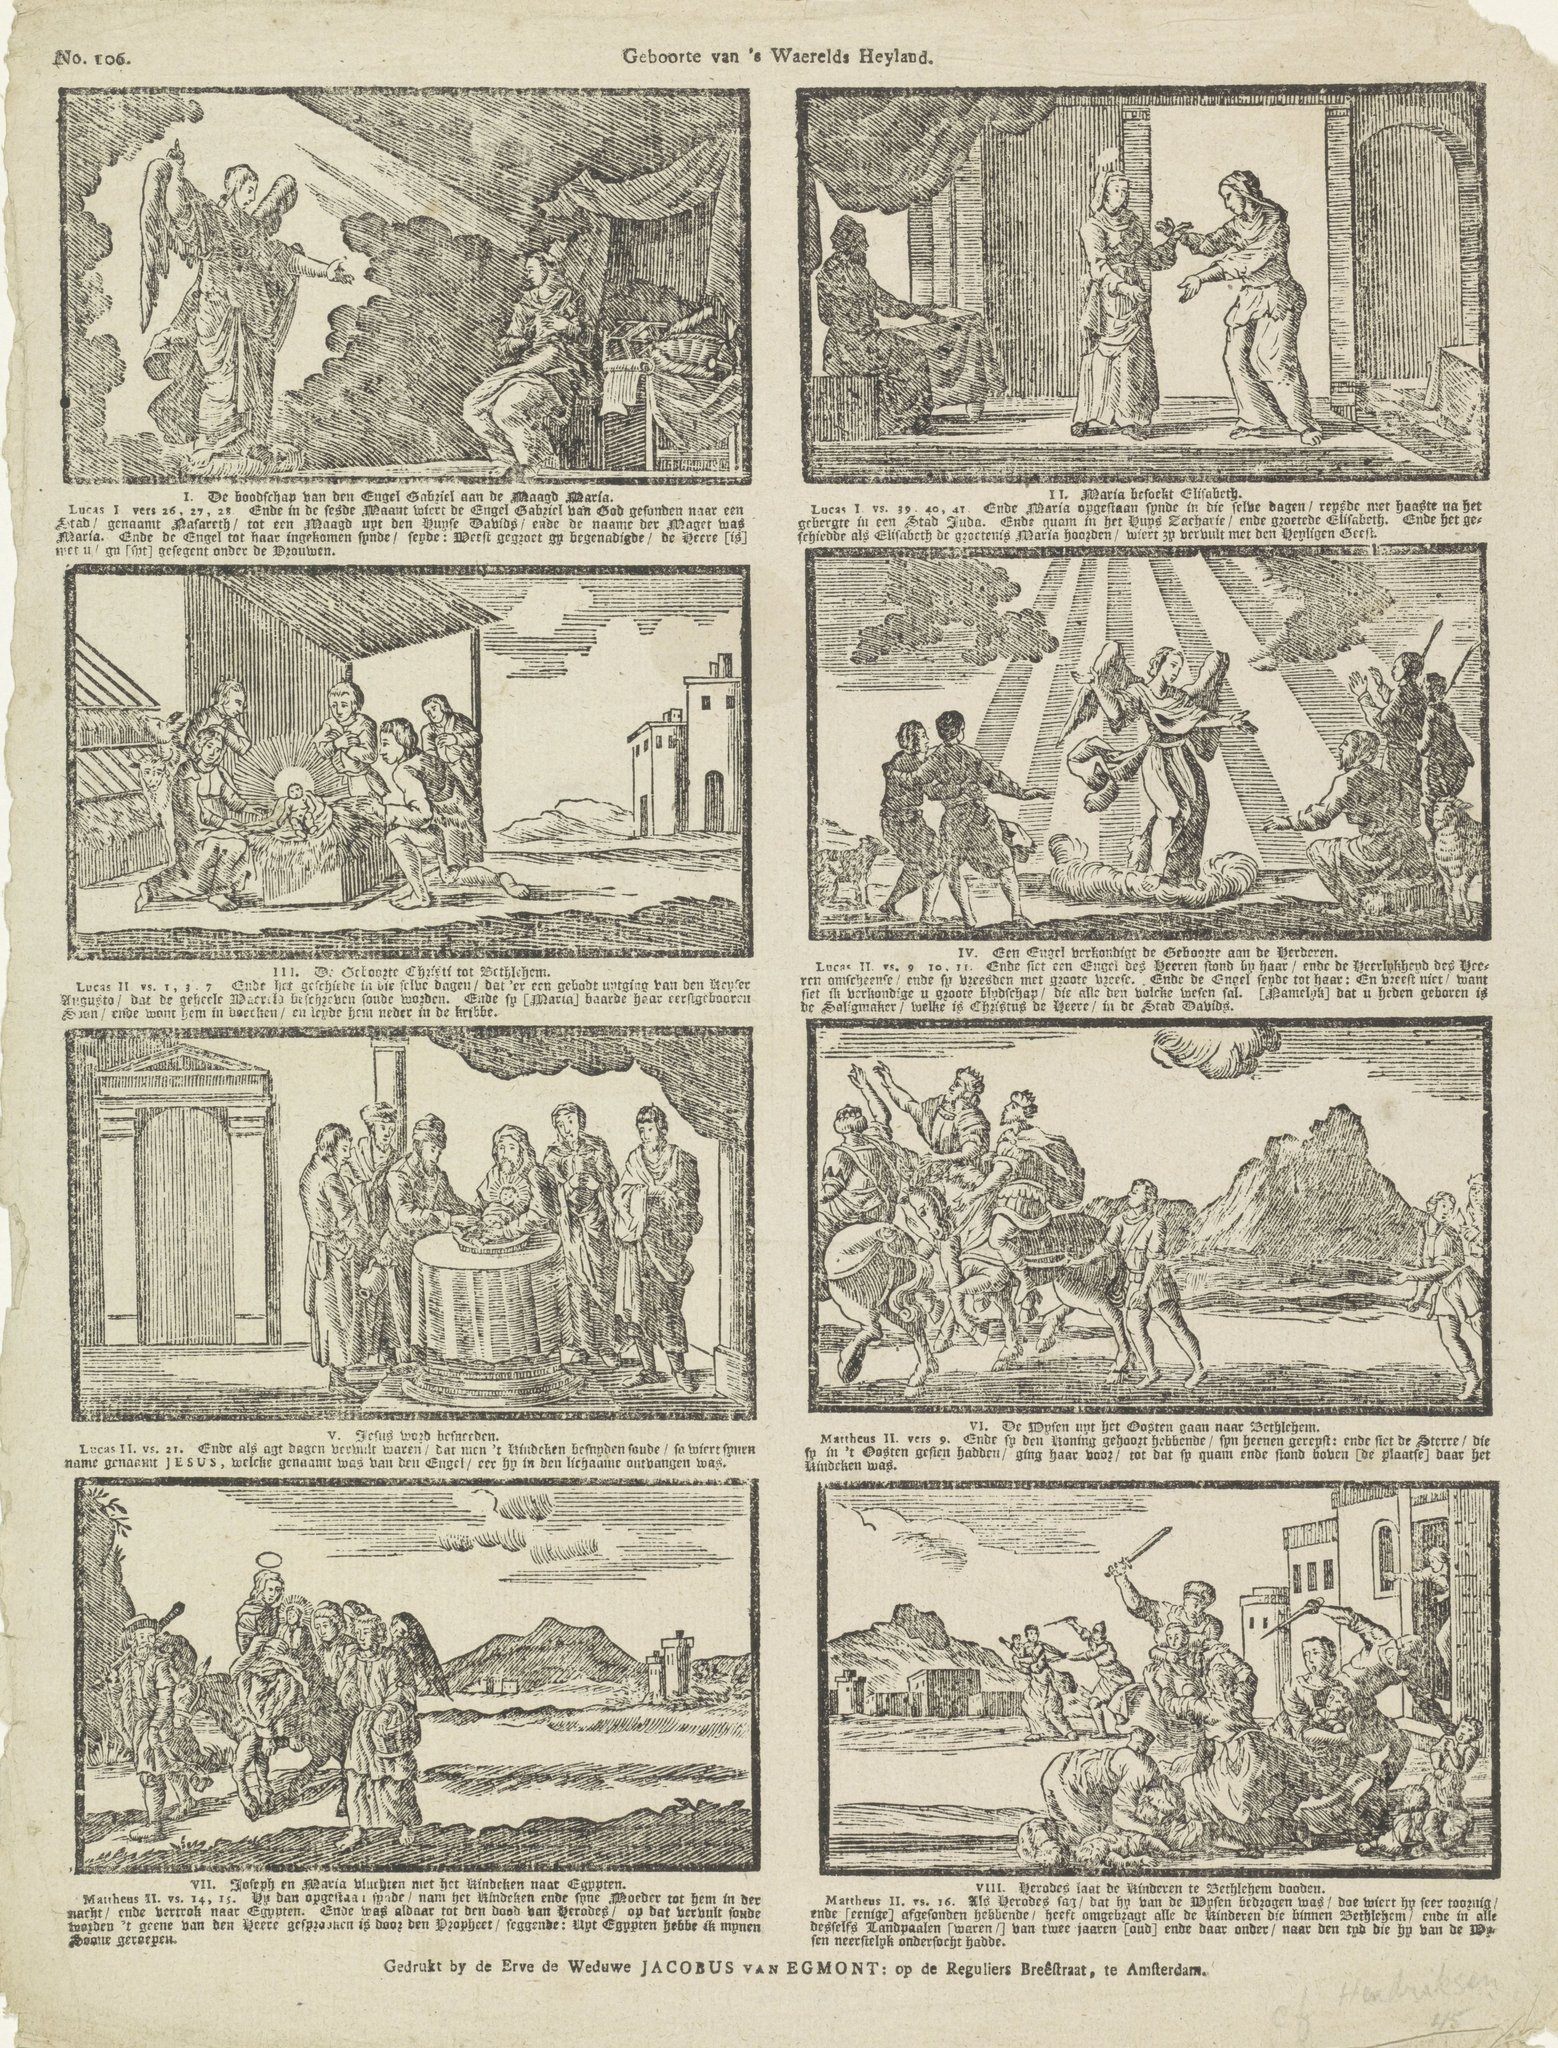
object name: popular print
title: Geboorte van 's weerelds Heyland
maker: Anonymous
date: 1761-1804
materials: paper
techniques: letterpress printing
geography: amsterdam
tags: series of scenes from the life of christ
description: Blad met 8 voorstellingen uit het leven van Christus, waaronder de geboorte van Christus, de besnijdenis en de vlucht naar Egypte. Onder elke voorstelling een bijbehorende Bijbeltekst. Genummerd linksboven: No. 106.